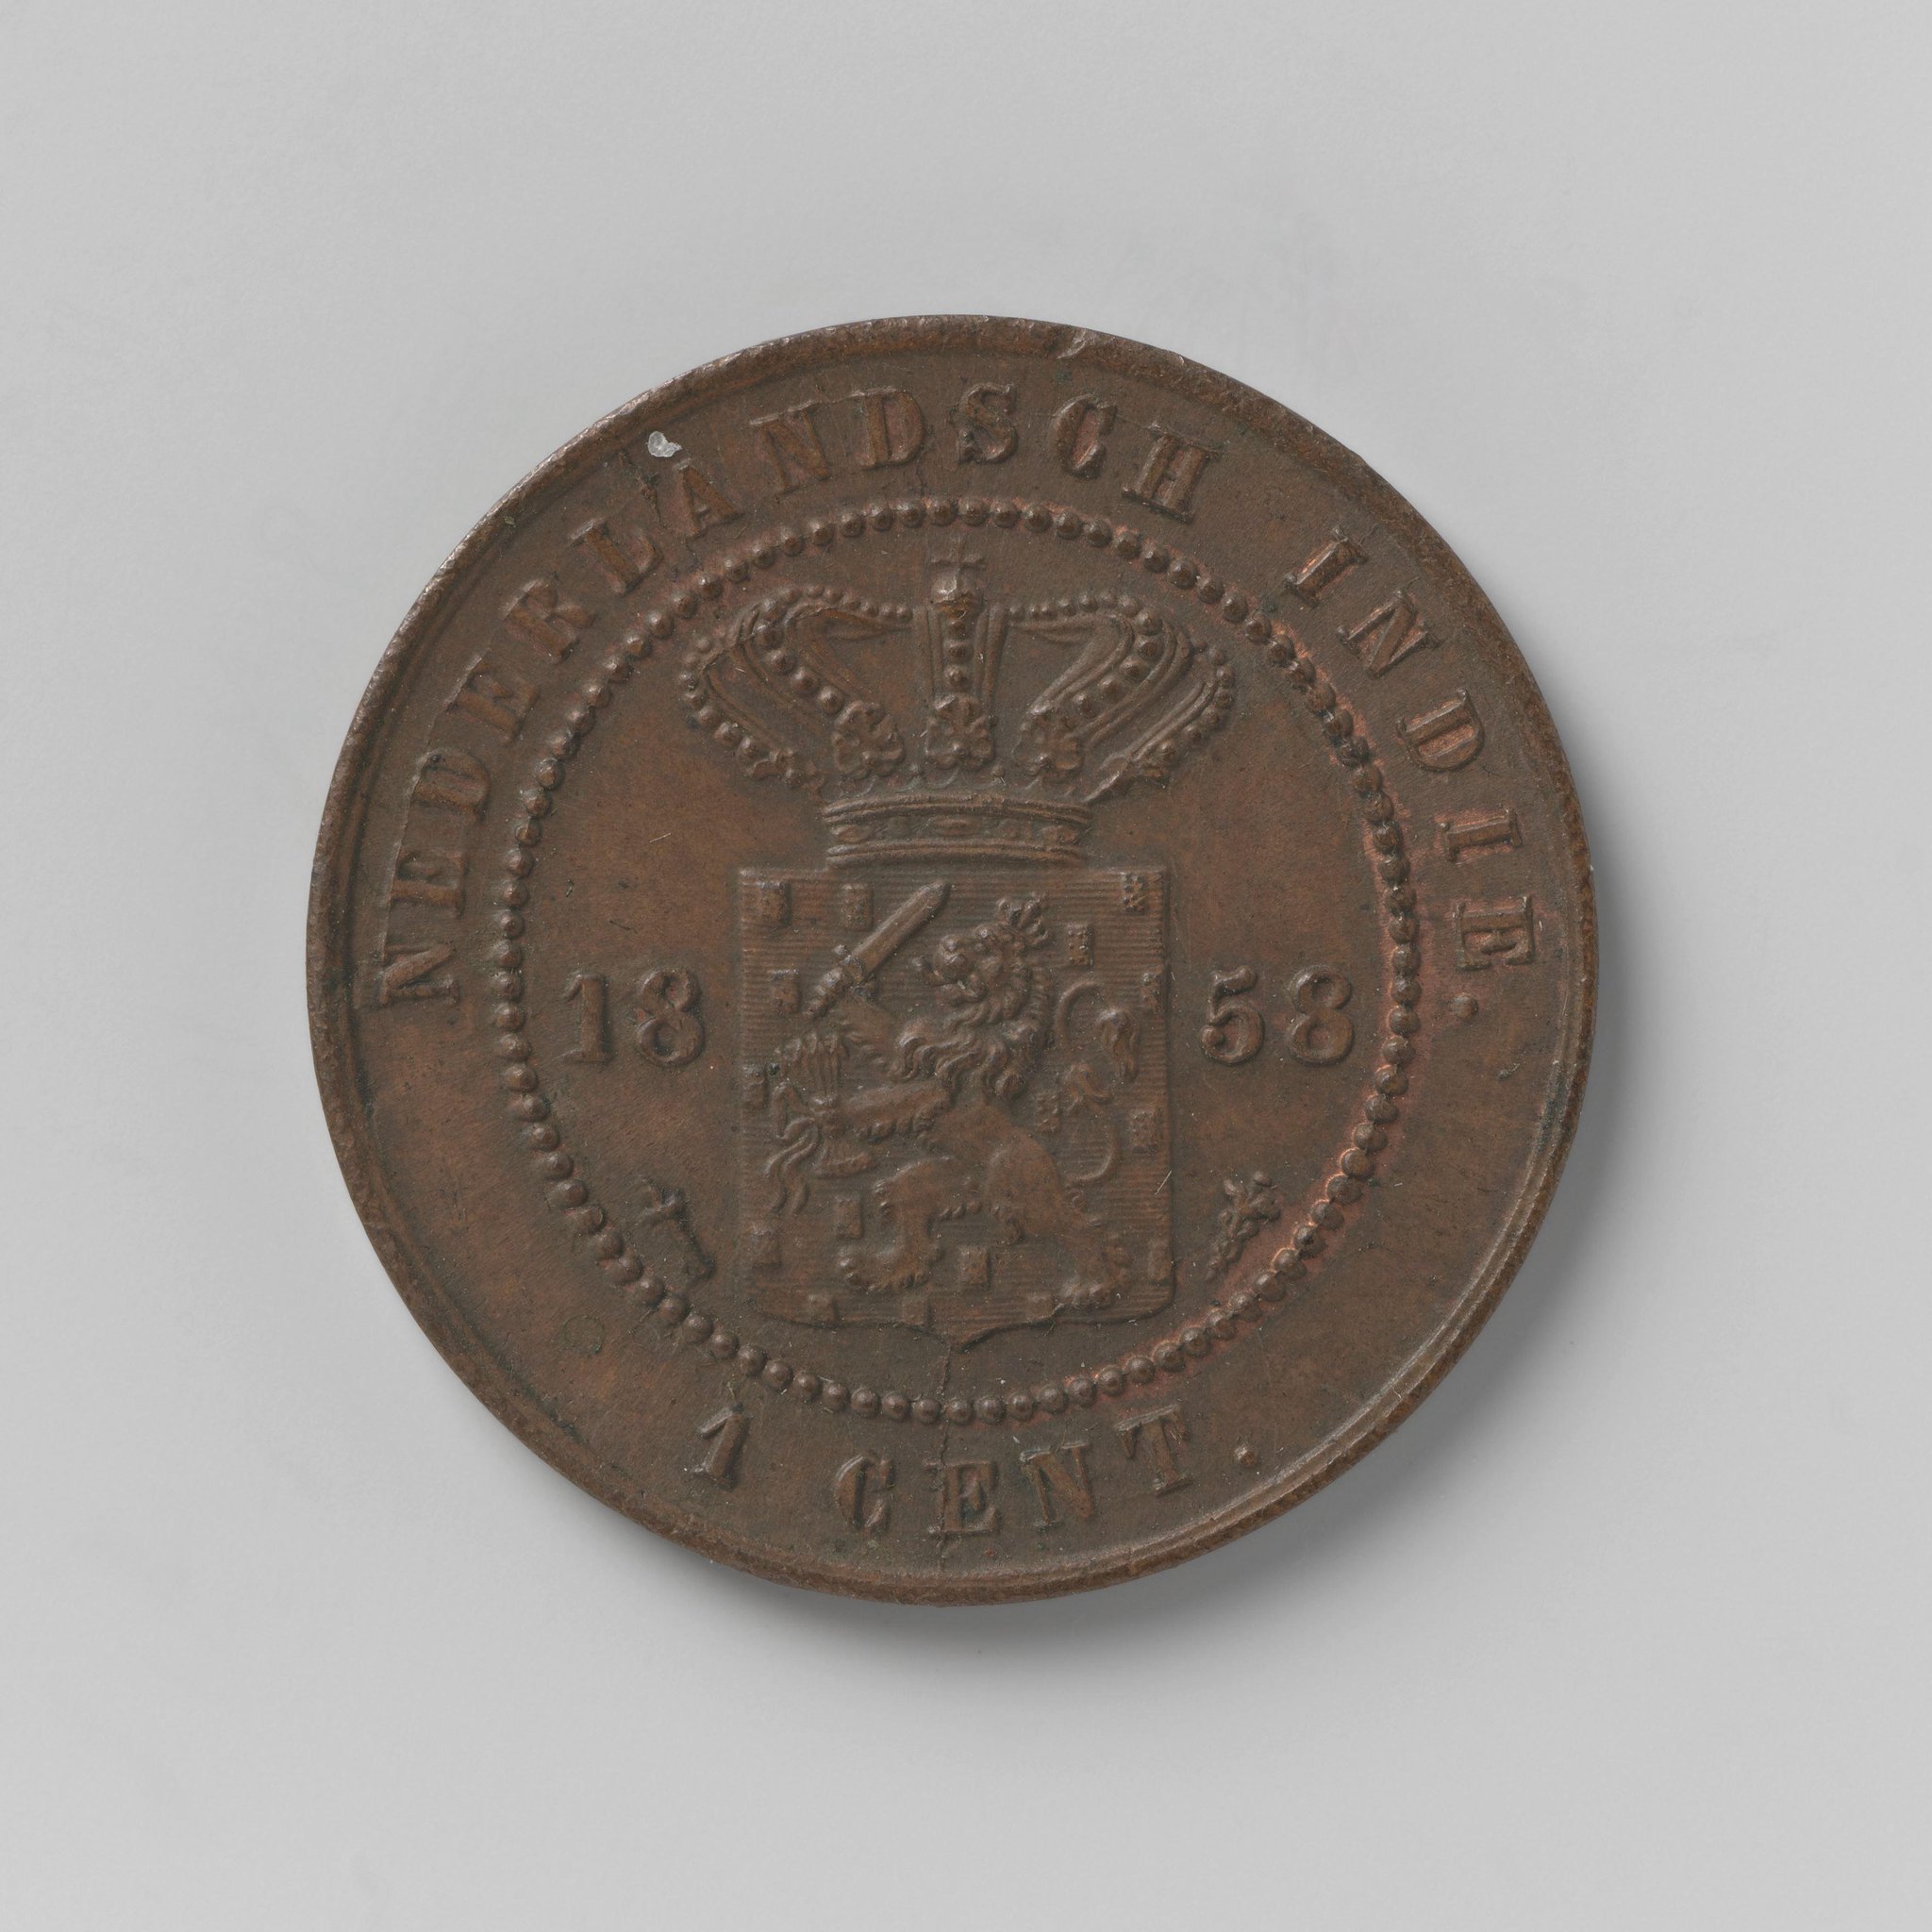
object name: coin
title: Nederlands Indië, cent,1858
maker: willem iii (koning der nederlanden)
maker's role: koning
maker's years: 1817-1890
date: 1858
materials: copper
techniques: striking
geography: utrecht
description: Koperen munt. Voorzijde: tussen jaartal gekroond rijkswapenschild. Boven kroon landsaanduiding en onder wapenschild waarde-aanduiding. Keerzijde: tweeregelig Maleis opschrift in Arabische tekens, waaromheen omschrift in het Javaans. Gladde rand.